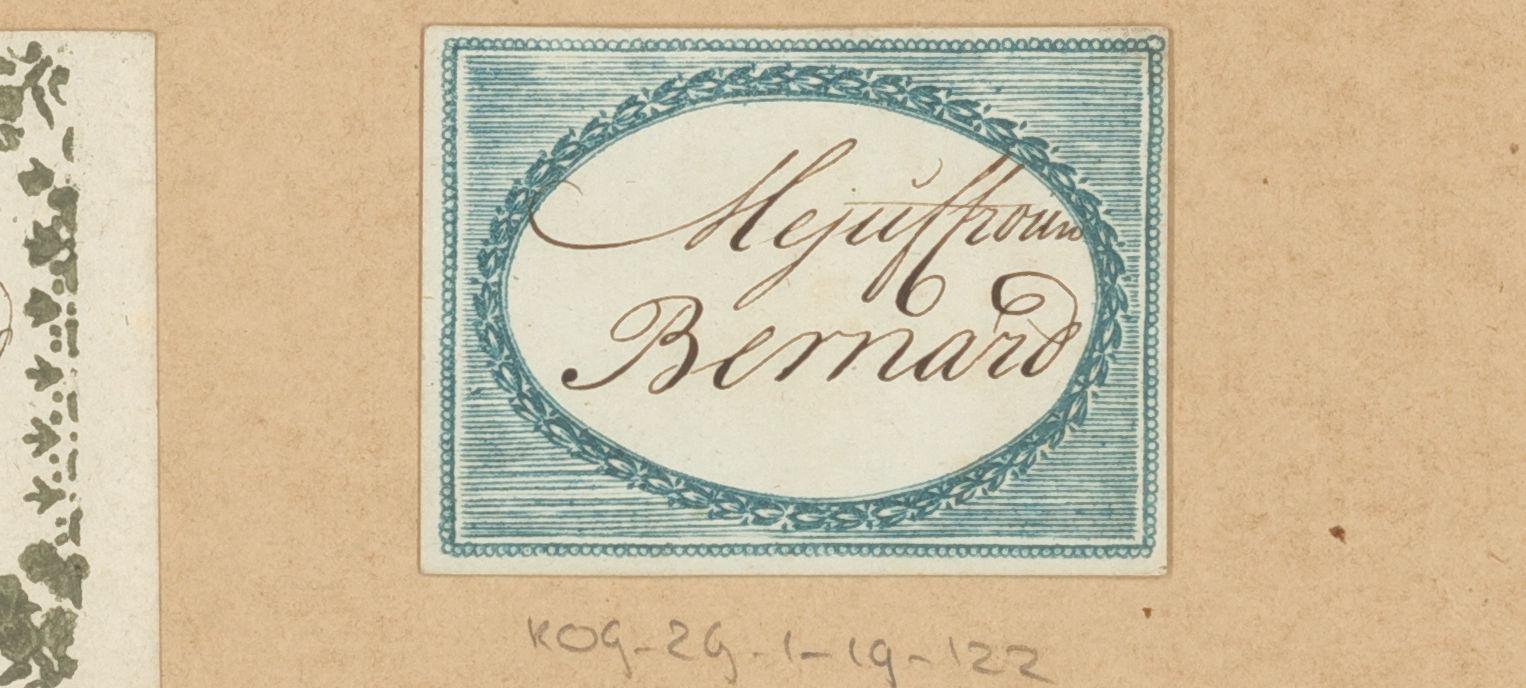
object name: print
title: Naamkaartje voor 'Mejuffrouw Bernard'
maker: Anonymous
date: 1792-1799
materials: paper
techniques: engraving, etching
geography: netherlands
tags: johanna magdalena schnetzler, wedding feast, wedding meal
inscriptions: collector's mark: Lugt 1641, collector's mark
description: Naamkaartje voor Johanna Magdalena Schnetzler, de echtgenote van Jean Bernard, te gebruiken bij de tafelindeling bij een bruilofts- of andere feestmaal. Onderdeel van een groep van bruilofts- en invitatiekaartjes van de families Bernard en Metayer. Onderwerpsrubrieken binnen de Atlas Zeden en Gewoonten: Des Menschen Begin, Midden en Einde. Bruiloft en huwelijk.